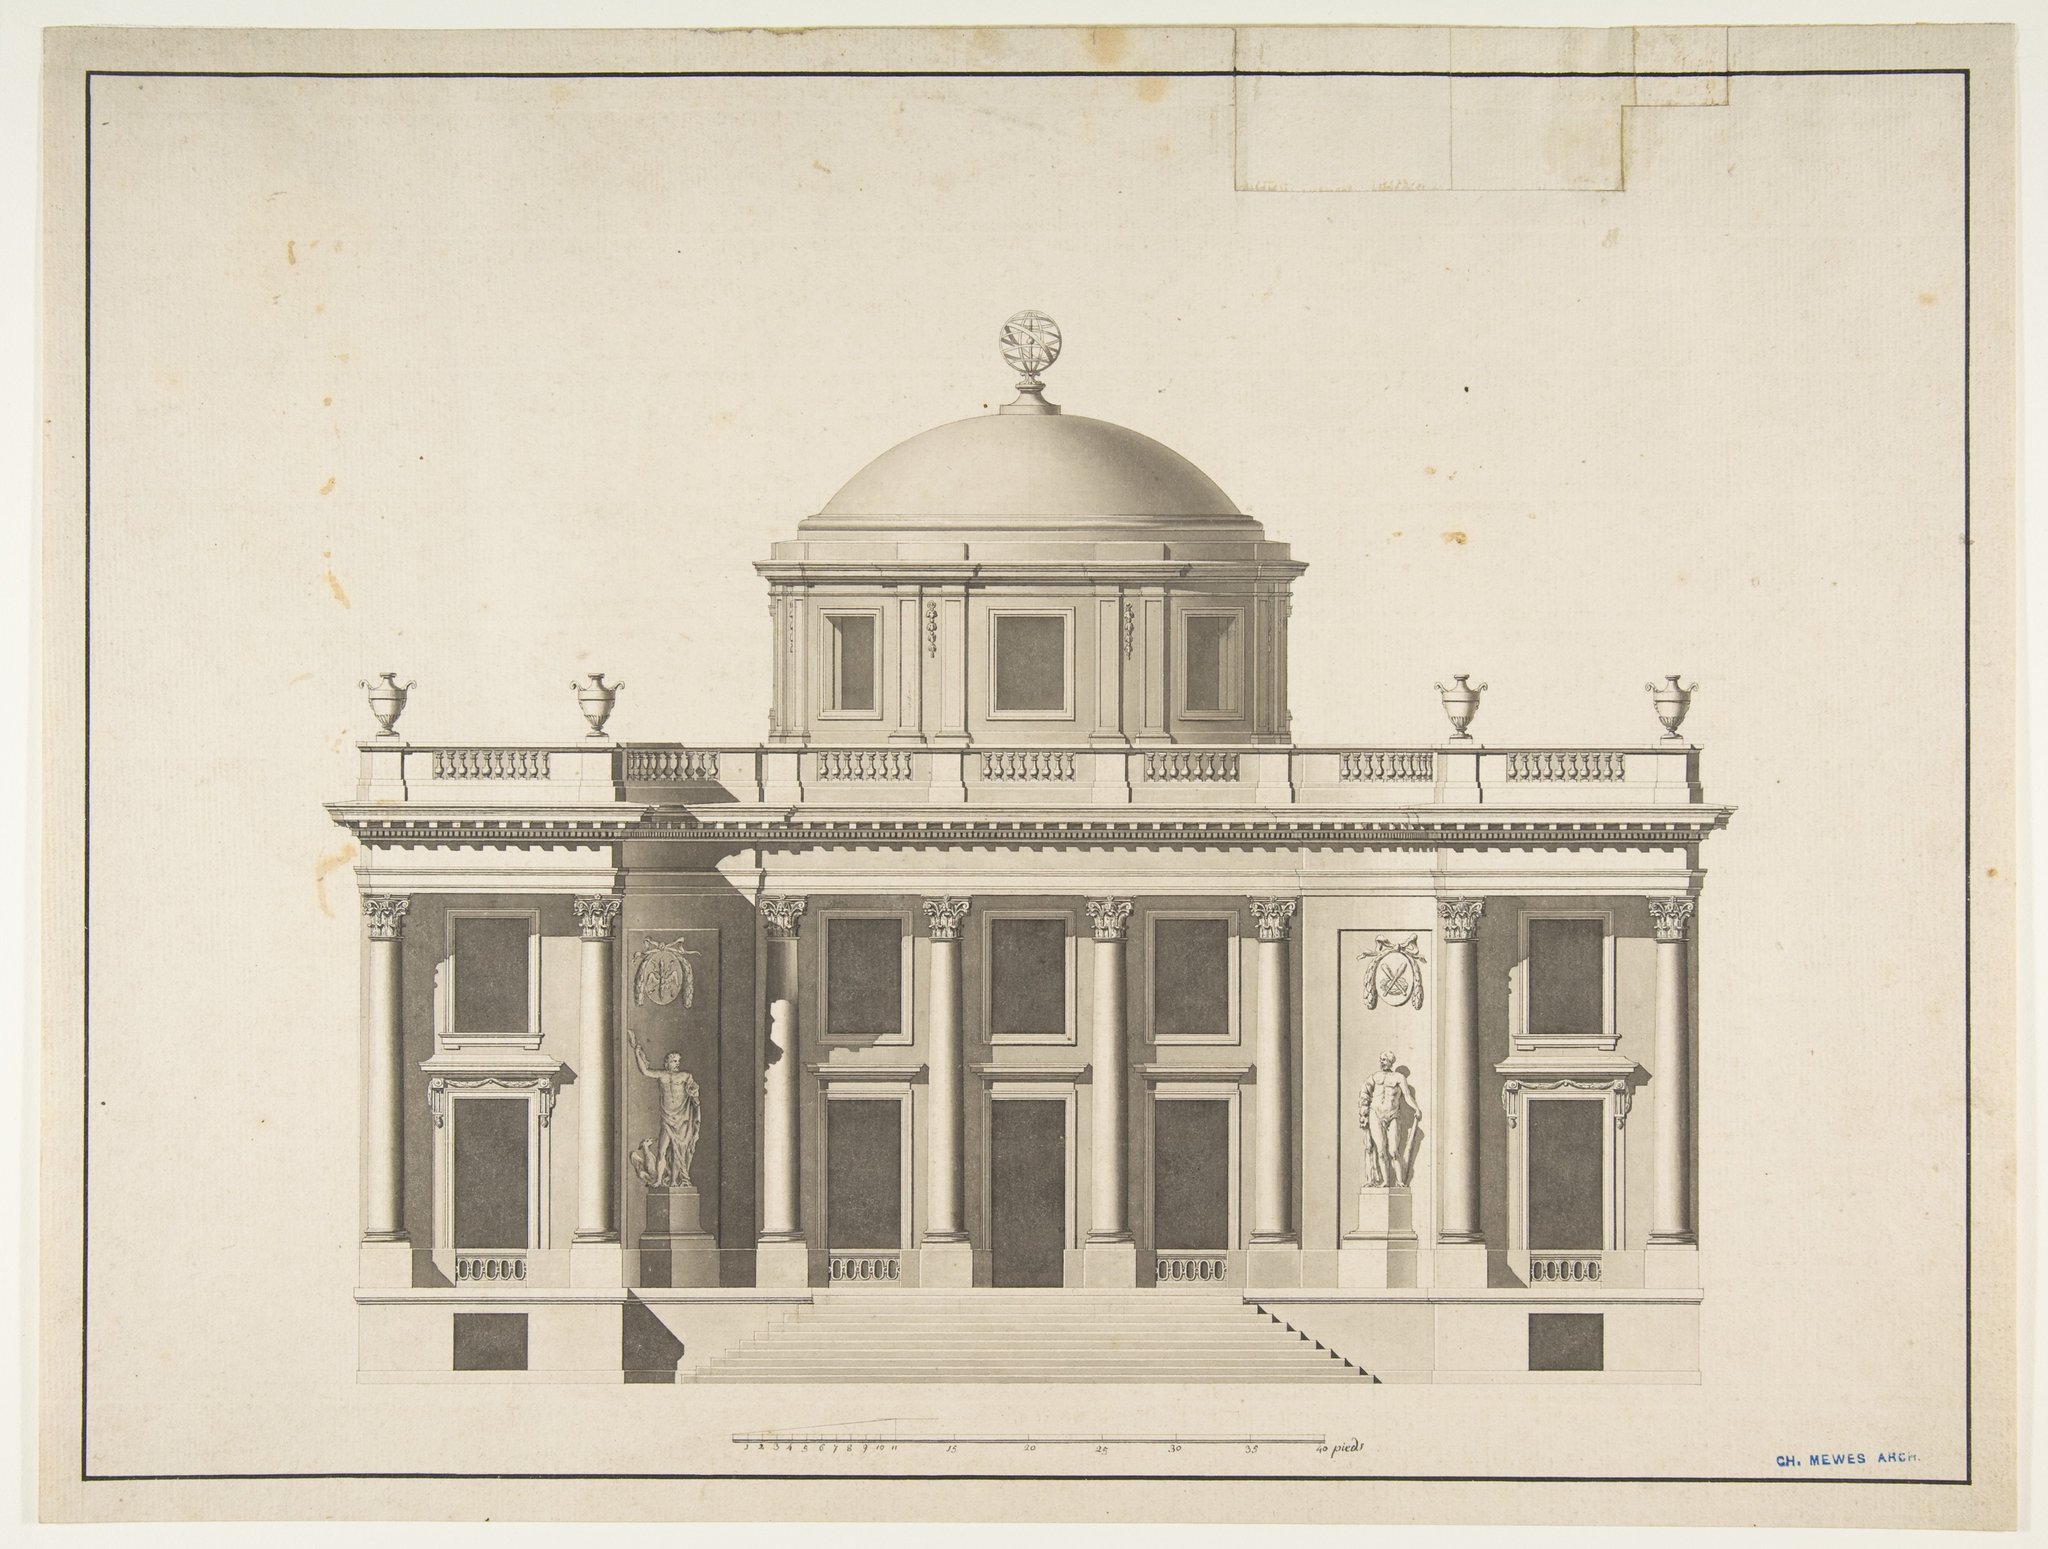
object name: drawing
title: Project for a Domed Building with Colonnaded Façade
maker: anonymous, french, 18th century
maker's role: artist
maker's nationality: french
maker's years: 1700-1800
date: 1767-1800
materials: ink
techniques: brush, pen, wash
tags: architecture